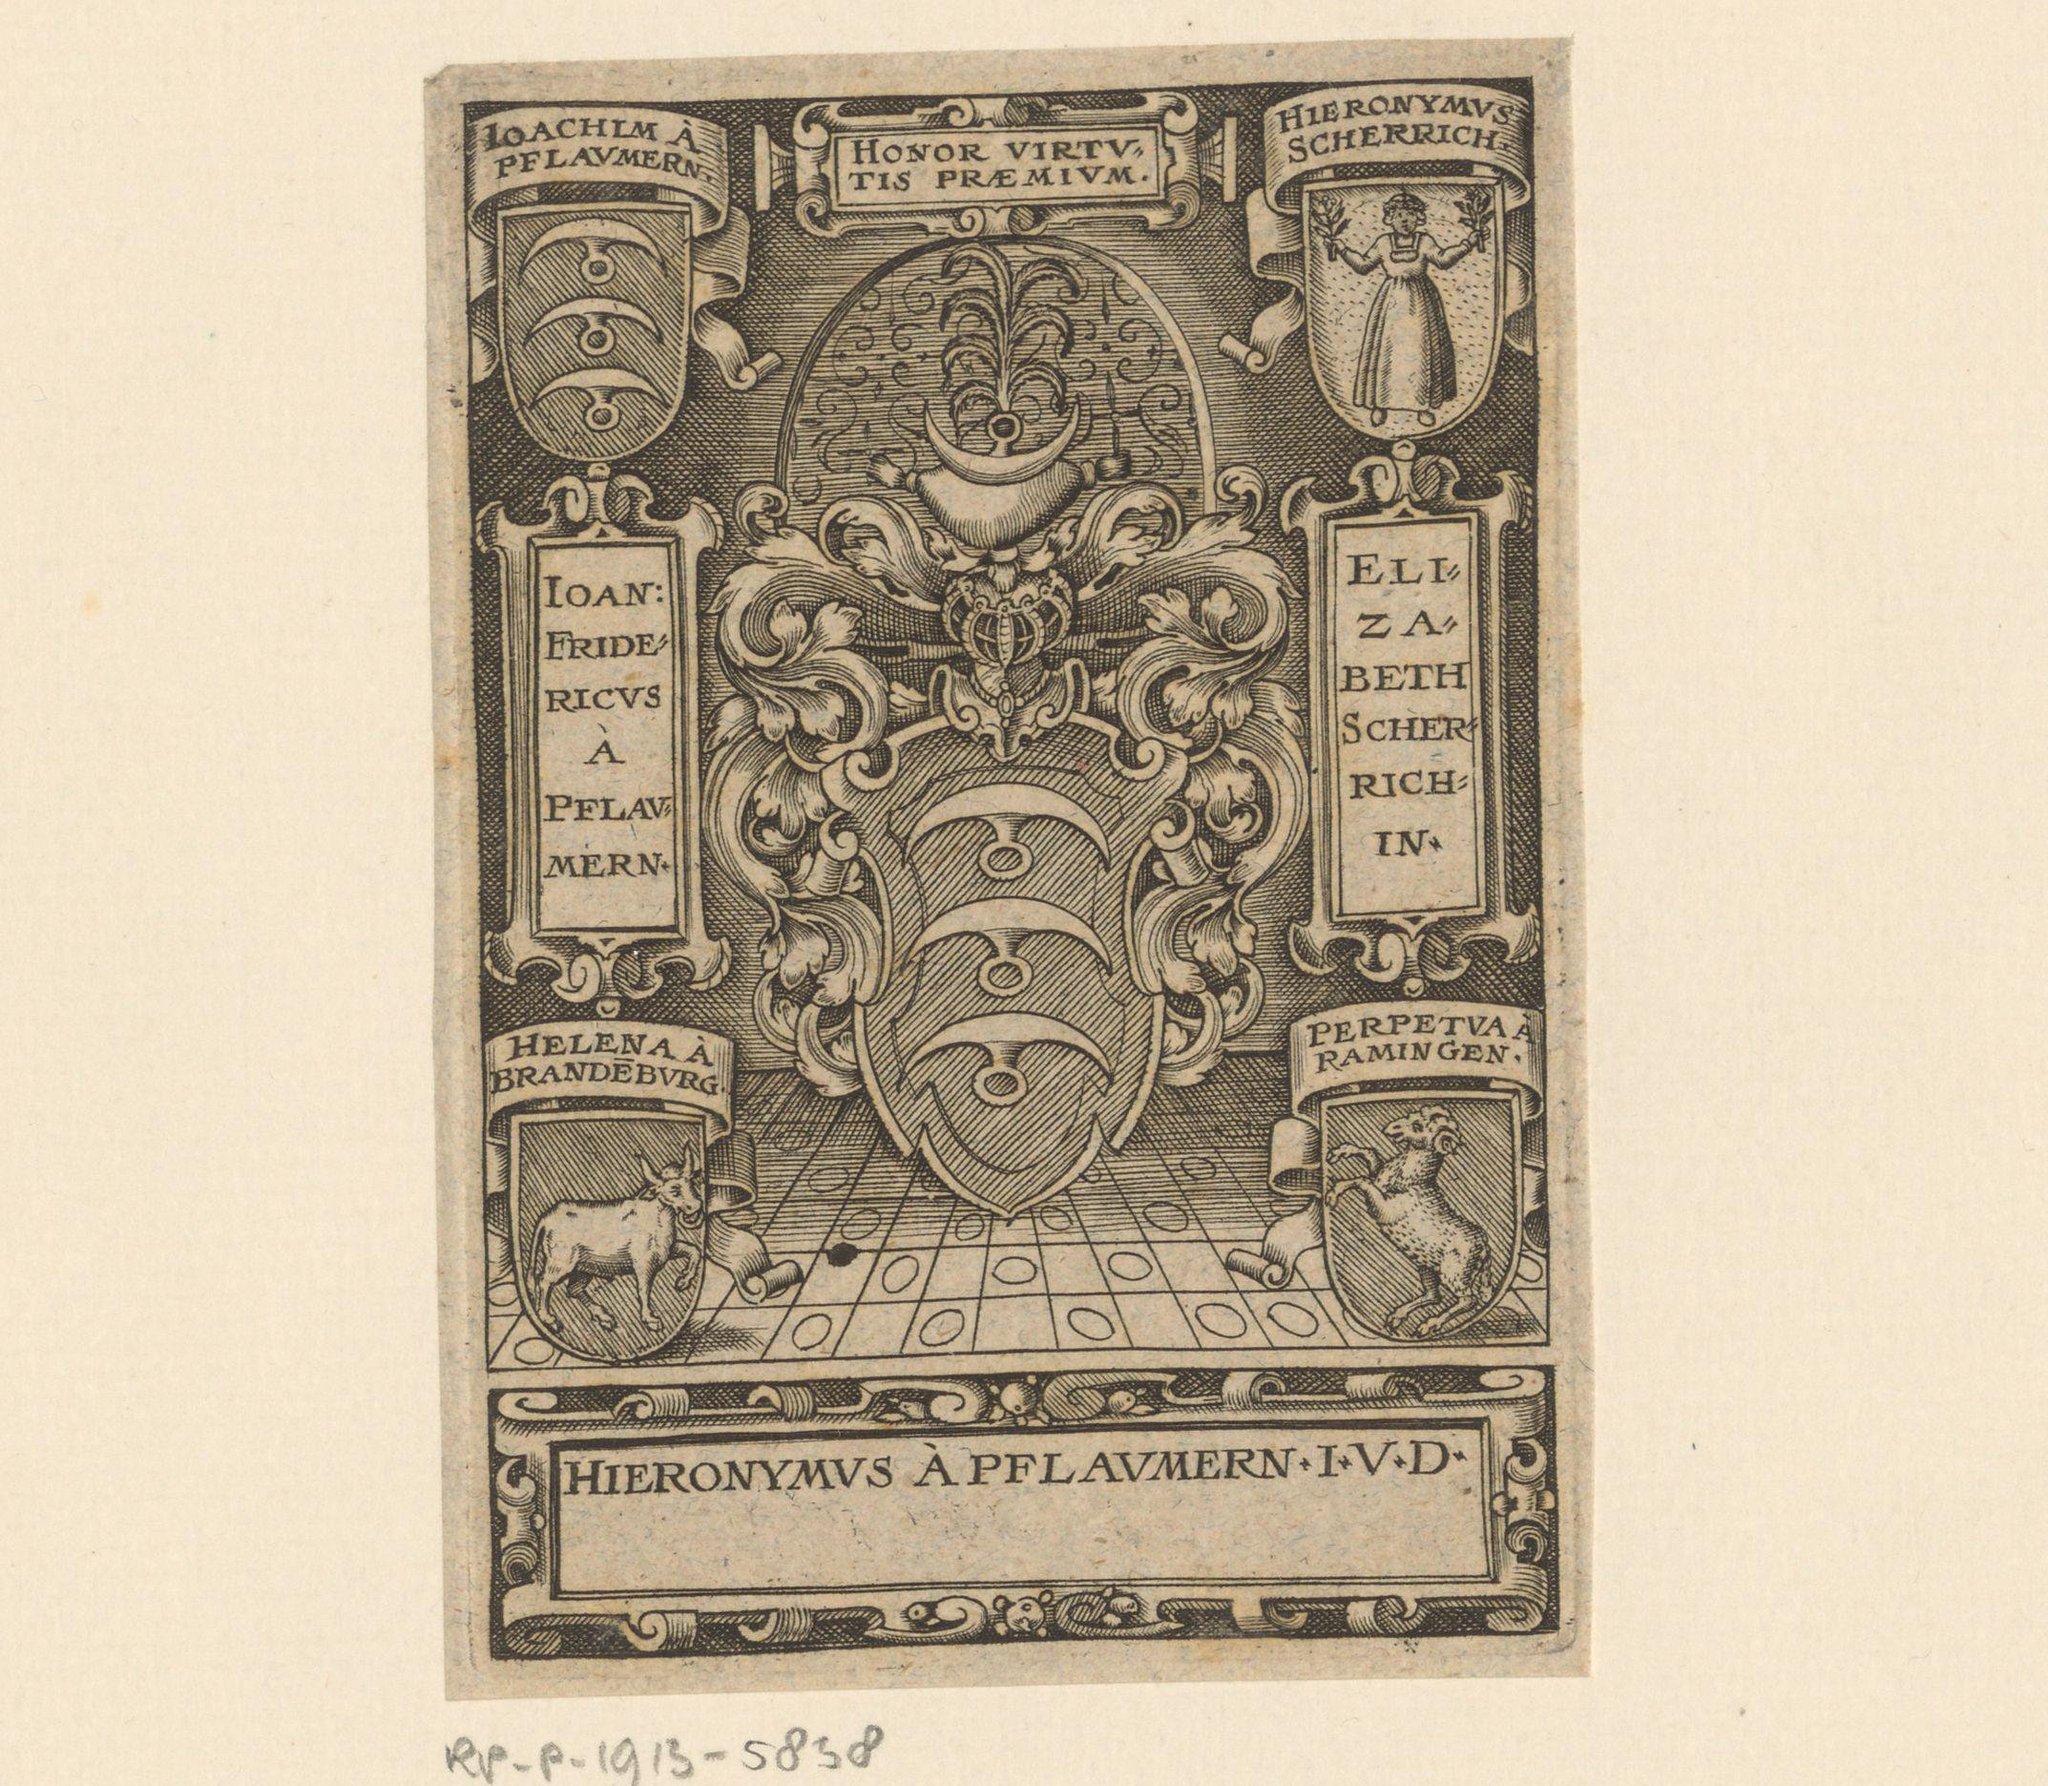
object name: bookplate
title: Honor virtutis praemium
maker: Anonymous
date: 1600-1700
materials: paper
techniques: engraving, etching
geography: germany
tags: ram, ox, armorial bearing, heraldry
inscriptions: collector's mark: Lugt 2233, inscription: ‘W 1575’, collector's mark: Lugt 2760